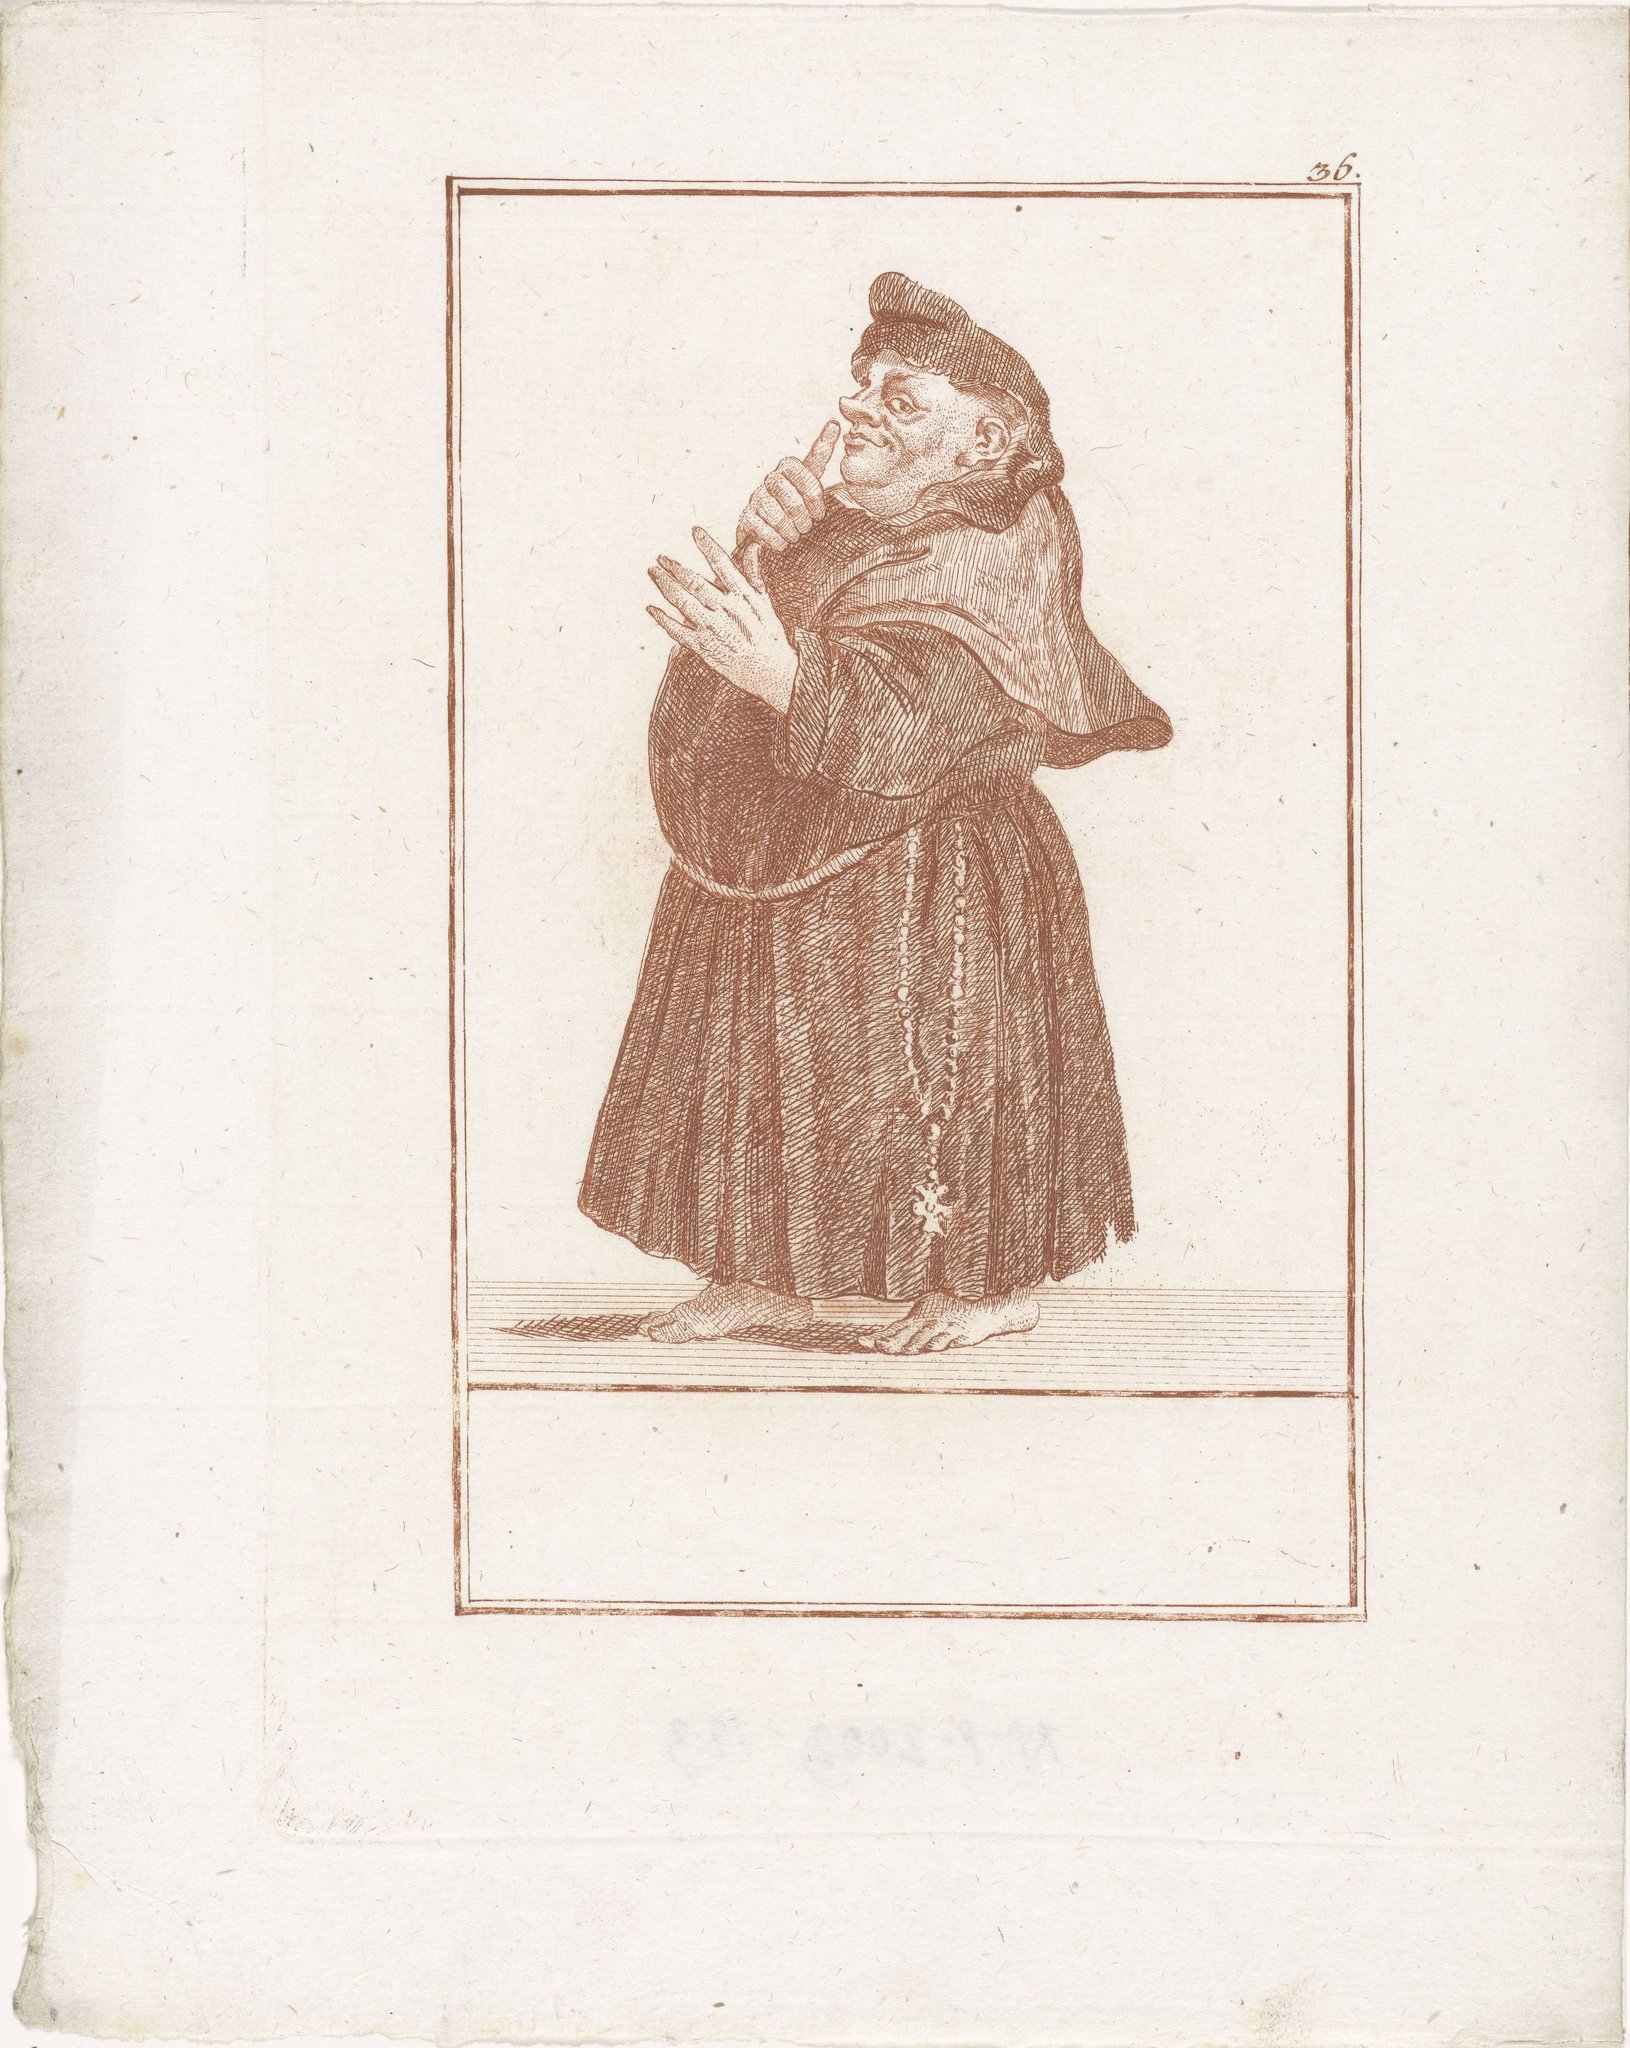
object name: cartoon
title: Misbruiken van de katholieke geestelijkheid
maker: jacob gole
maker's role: print maker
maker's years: 1660-1724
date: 1724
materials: paper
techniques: etching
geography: amsterdam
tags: fat (human type), monk(s), friar(s), (aspects of) christian religion or the church (as institution) ridiculed, criticized, or caricaturized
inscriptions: collector's mark: Lugt 2228, collector's mark: Lugt 2760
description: Dikke monnik op blote voeten. Hij houdt de duim van zijn rechterhand voor de mond. De prent is deel van een 50-delige serie met als onderwerp de misbruiken van de katholieke geestelijkheid.